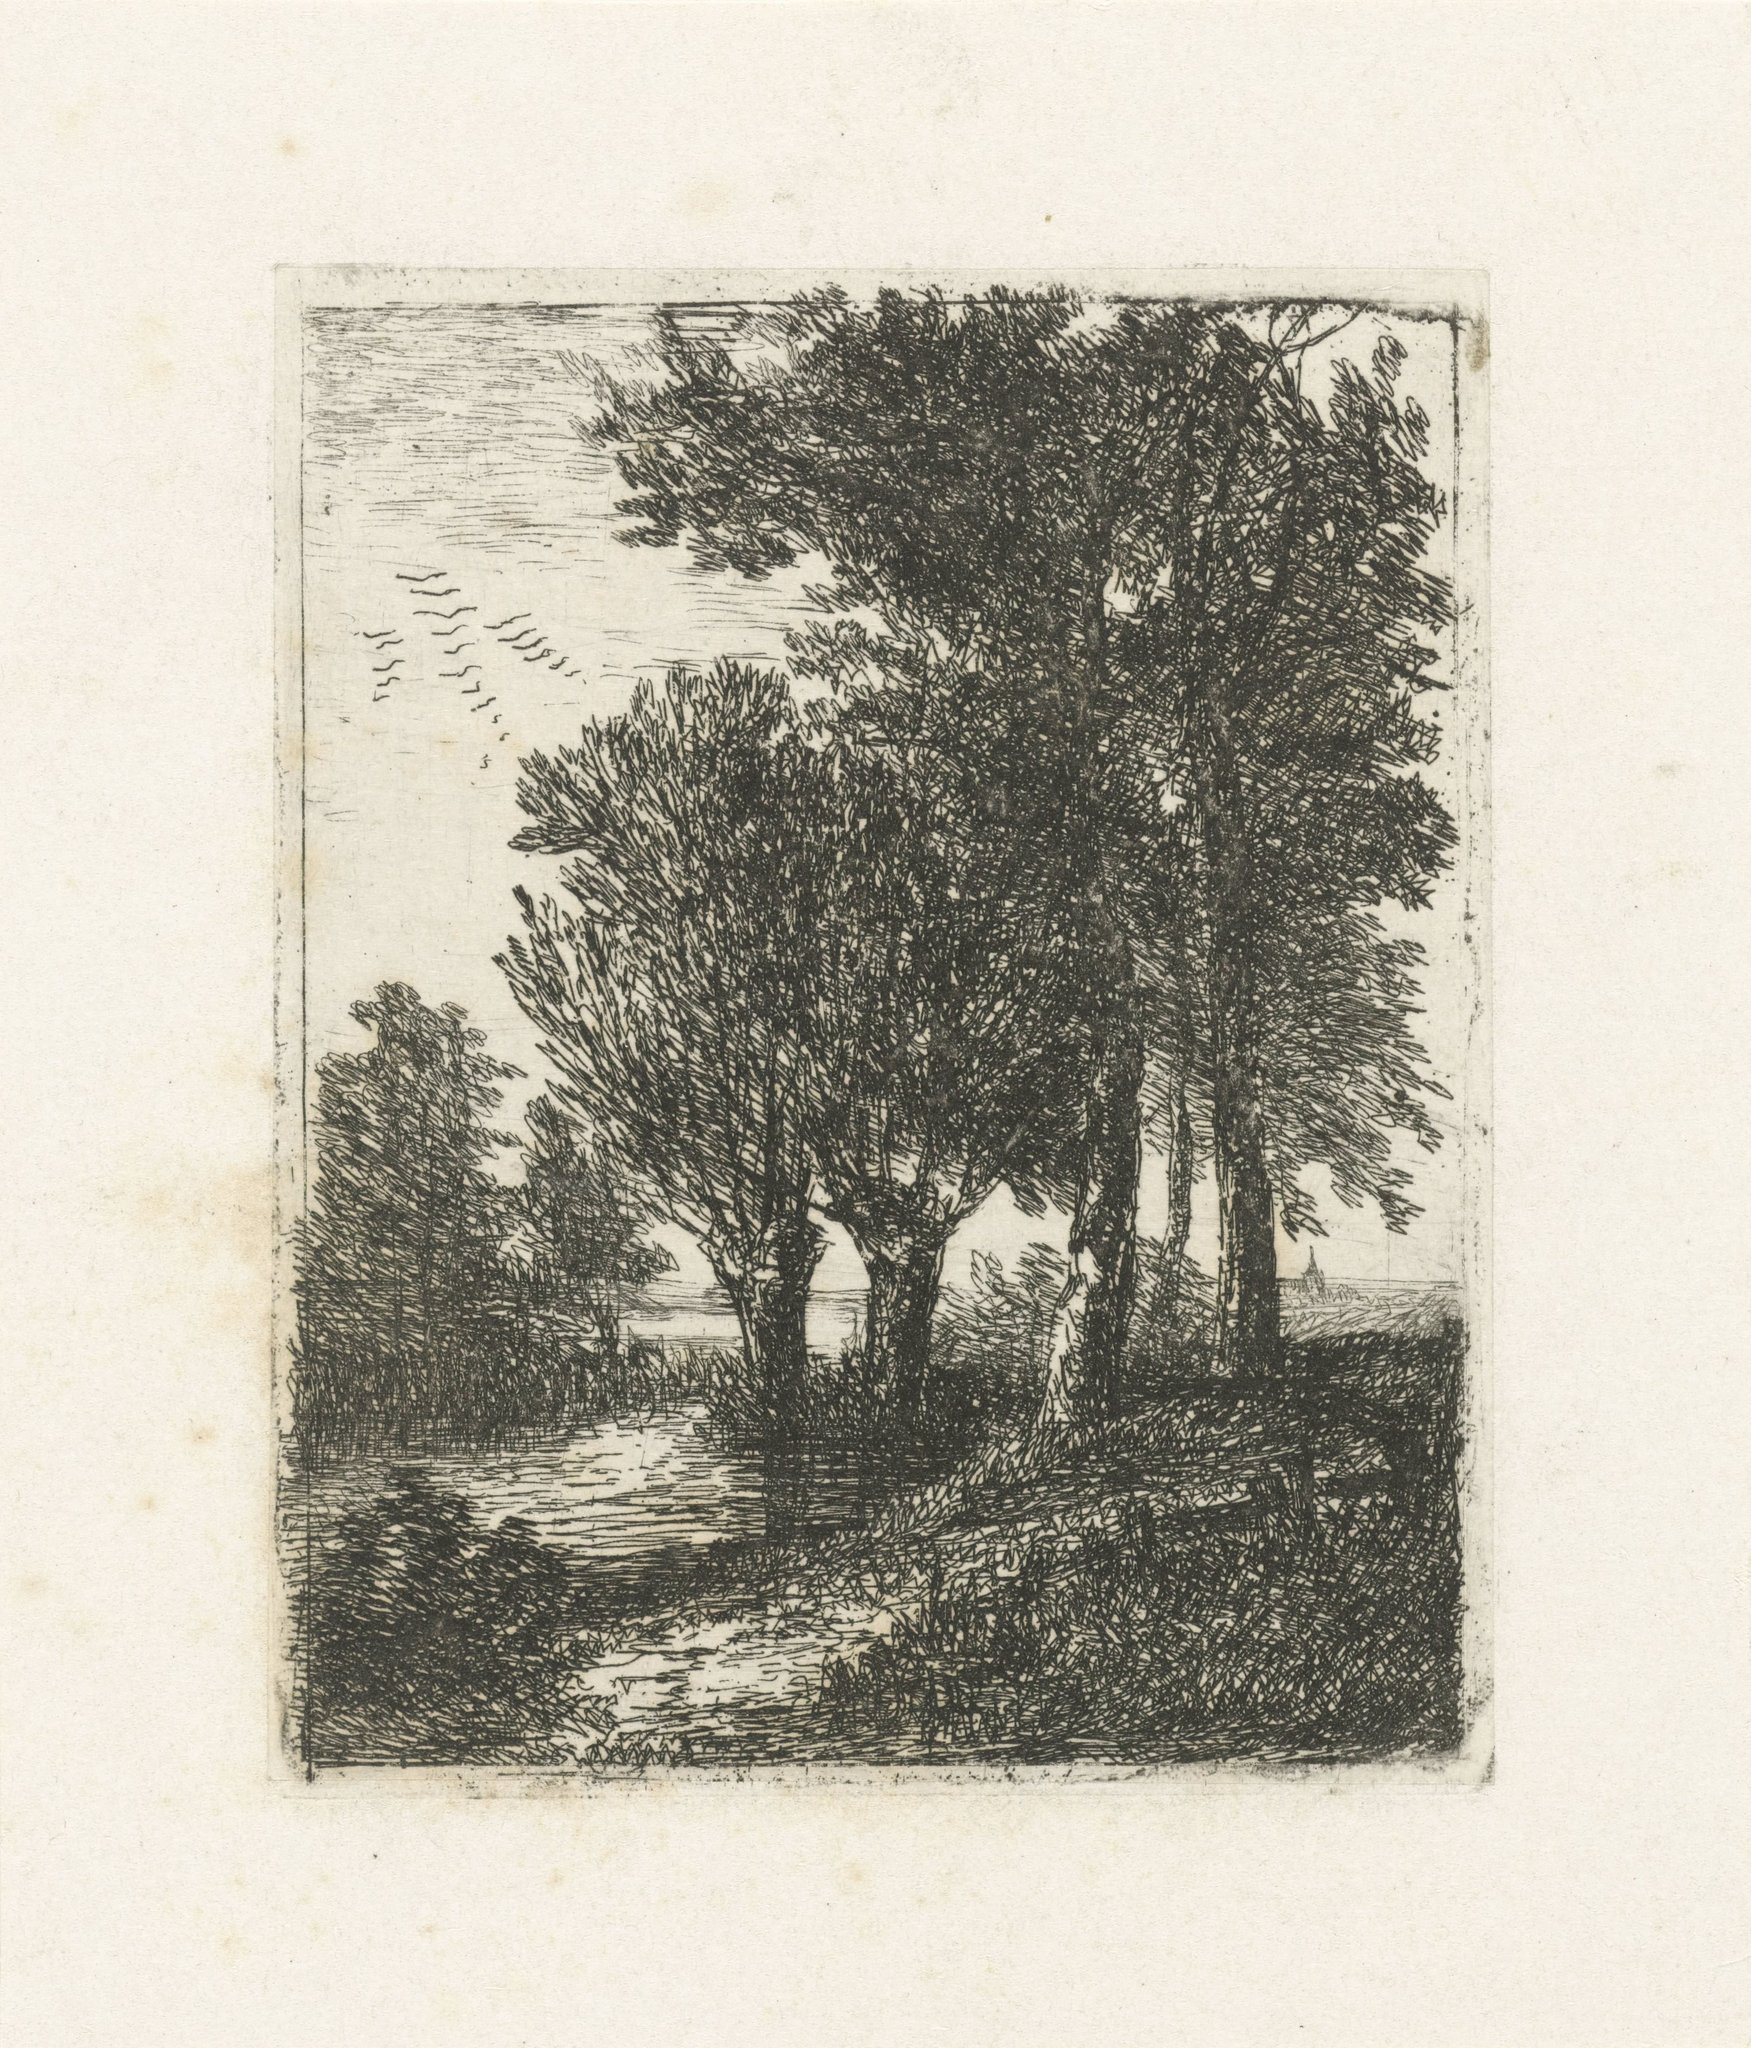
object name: print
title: Vijf bomen aan de waterkant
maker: hermanus jan hendrik van rijkelijkhuysen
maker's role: painter, print maker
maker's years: 1813-1883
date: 1823-1883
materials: paper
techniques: drypoint, etching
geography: utrecht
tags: trees, church (exterior), pond, pool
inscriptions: collector's mark: Lugt 1485, collector's mark: Lugt 2228